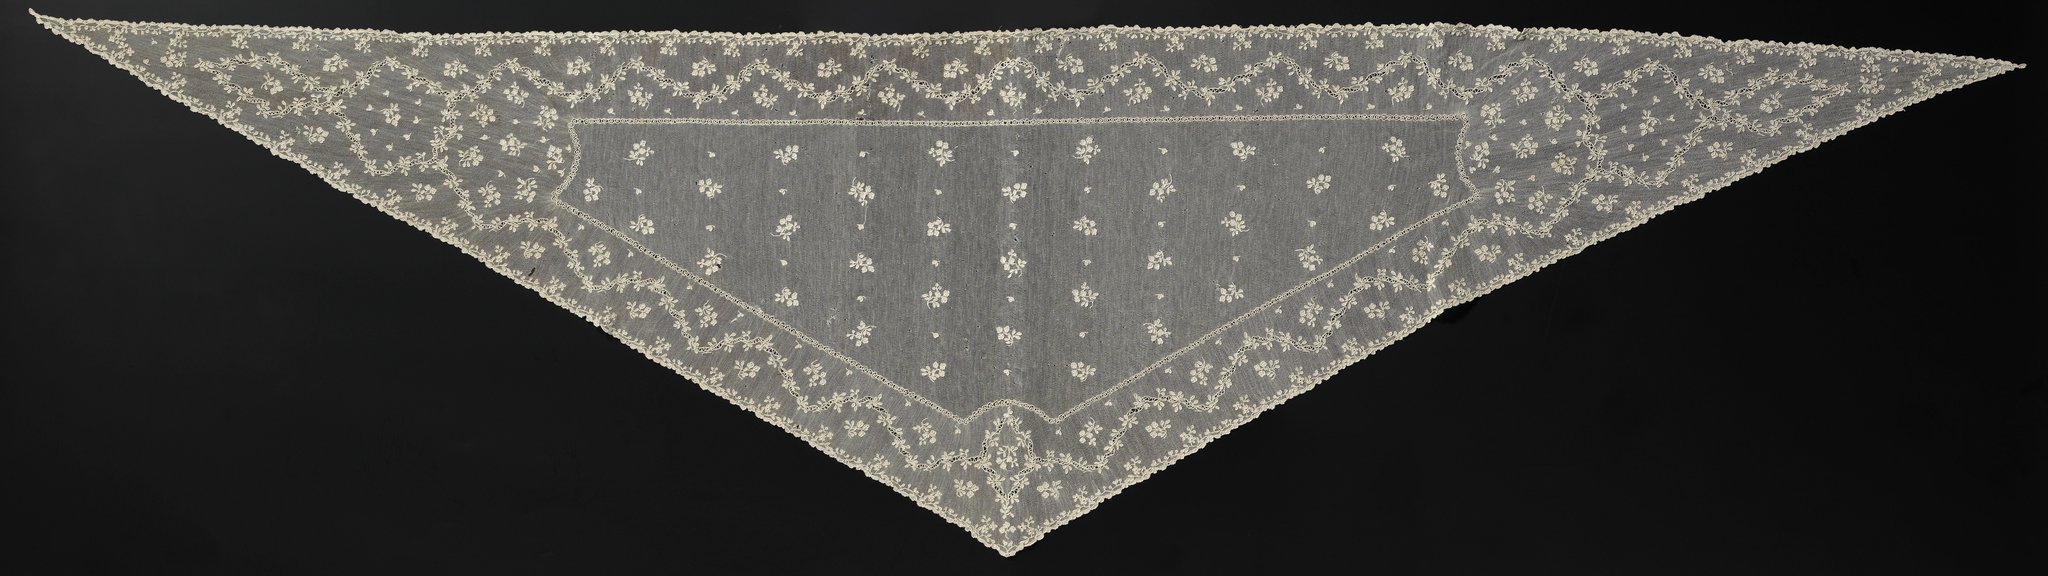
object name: fichu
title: Fichu van naaldkant met gestrooide takjes en rozenknopjes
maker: Anonymous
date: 1900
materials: silk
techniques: lace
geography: burano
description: Fichu van naturelkleurige naaldkant: Burano-kant. Driehoekig model. Het driehoekige middenveld heeft gestrooide takjes met rozenknopjes en is omsloten door een parellijstje. Om het middenveld heen loopt een brede rand met daarin een zigzagpatroon van een bladslinger. Deze slinger vormt vanuit de scherpe hoeken, richting het middenveld, een ruitvorm en twee in grootte toenemende vijfhoeken. Gedraaide festonsteken vormen de vierkante maasgrond in het middenveld, de brede rand is afzonderlijk gewerkt met straalsgewijs gerichte mazentoeren. De motieven zijn gemaakt met festonsteken en twee soorten open siersteken. De reliëfcontouren zijn gevuld en gefestonneerd. Aan alle zijden afgewerkt met een rijk versierd randje van boogjes en blaadjes.